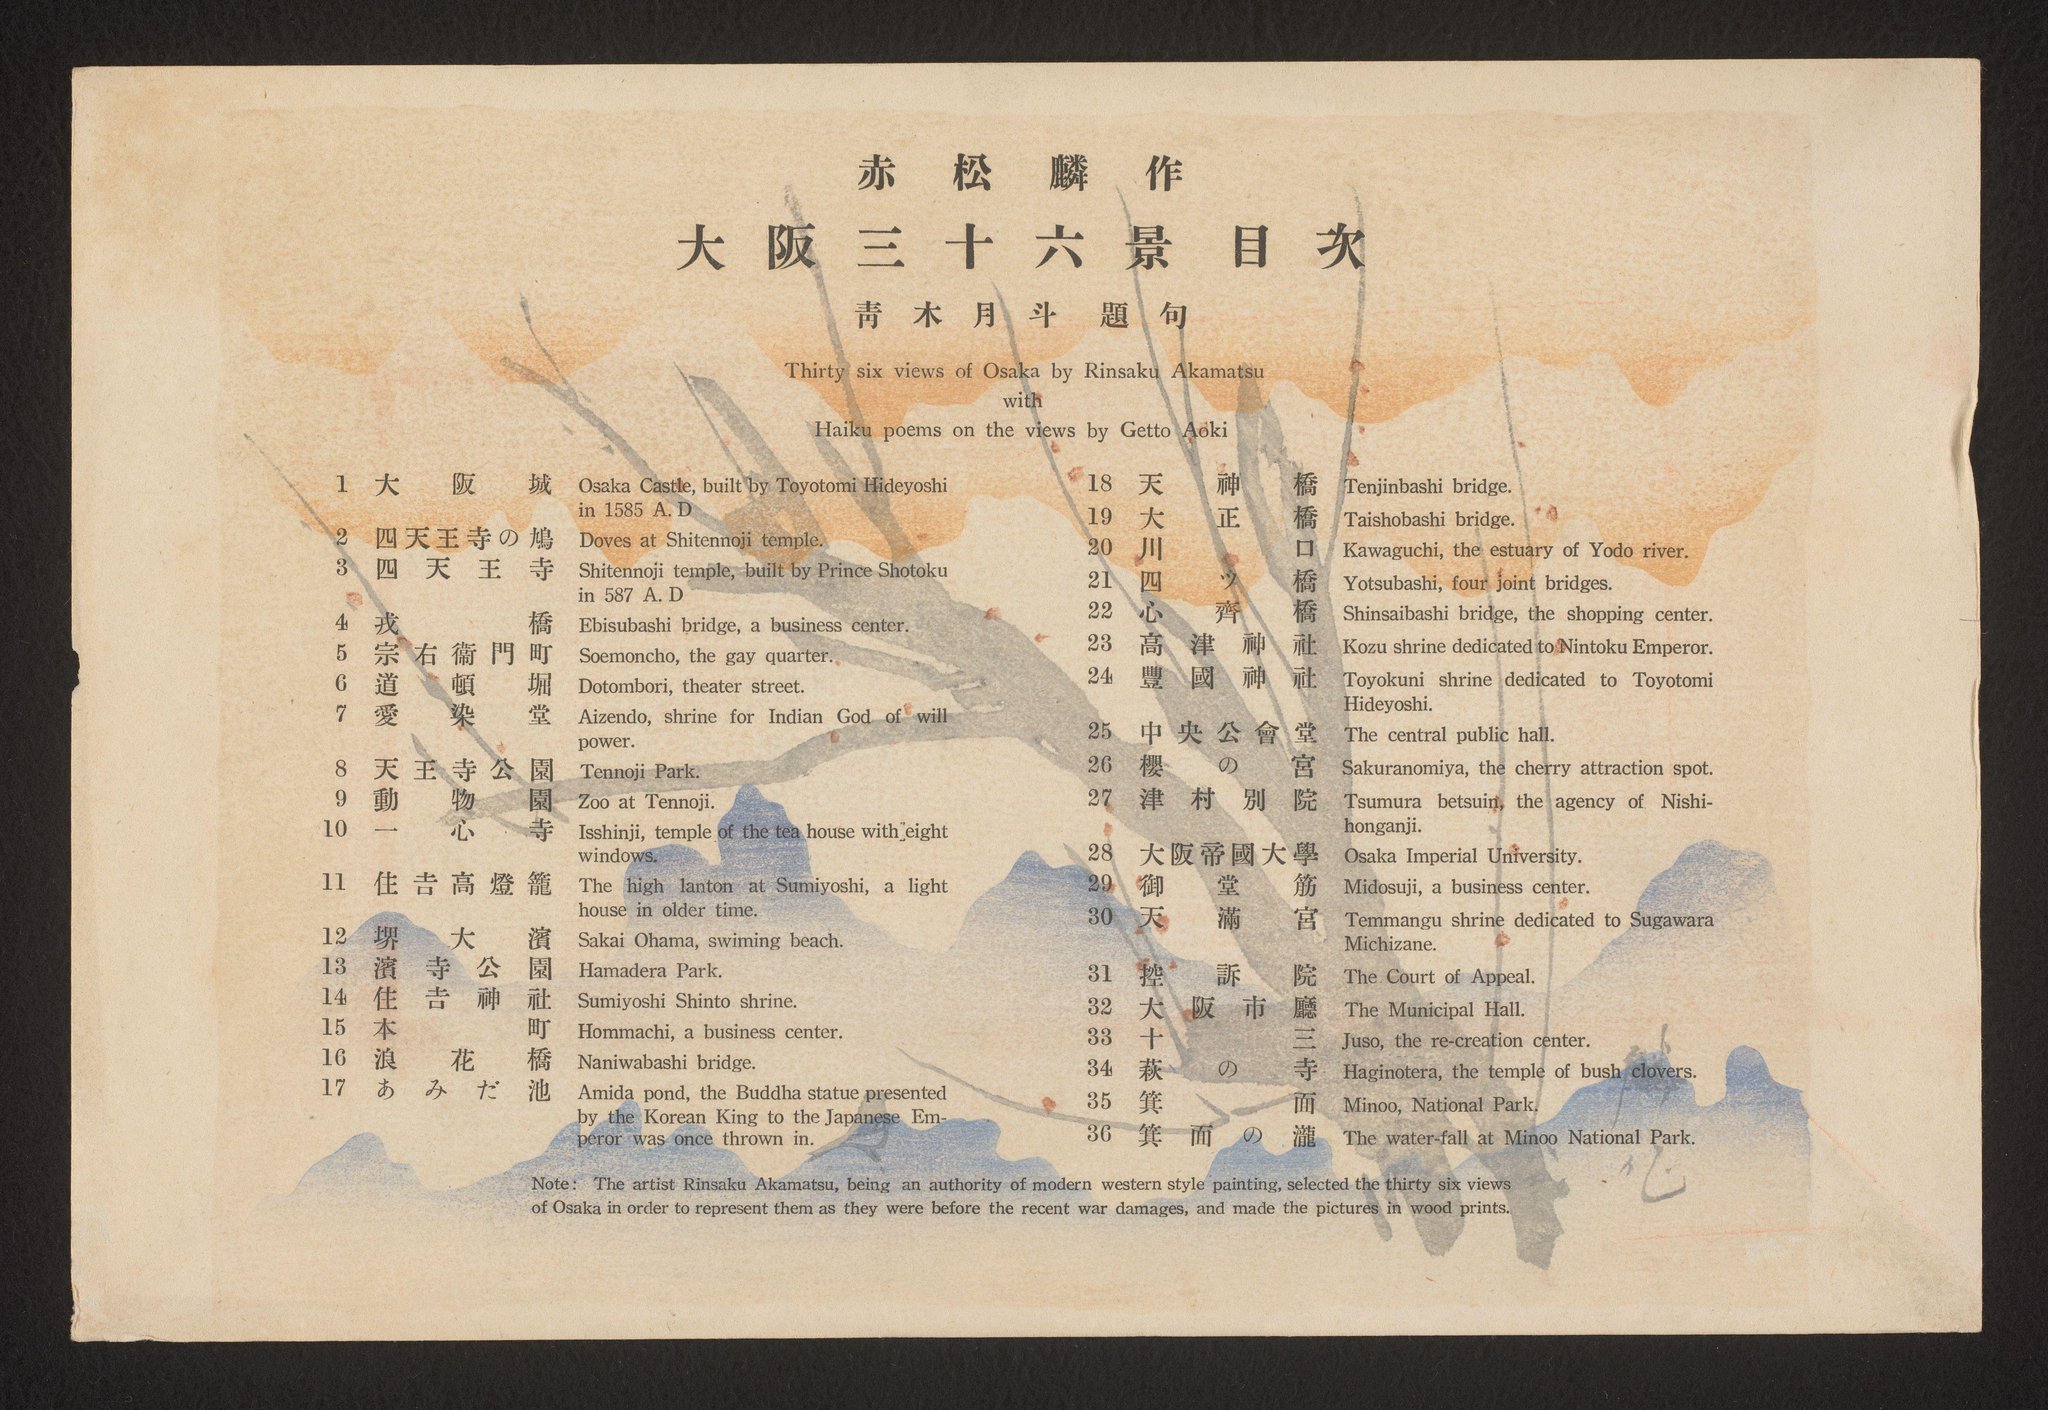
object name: print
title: Ôsaka sanjûrokkei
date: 1947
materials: paper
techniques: woodcut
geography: japan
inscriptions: date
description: Inhoudsopgave in het Engels van de 36 prenten in het portfolio. Op de achtergrond zijn blauwe bergen, oranje wolken en een silhouet van een boom afgebeeld.